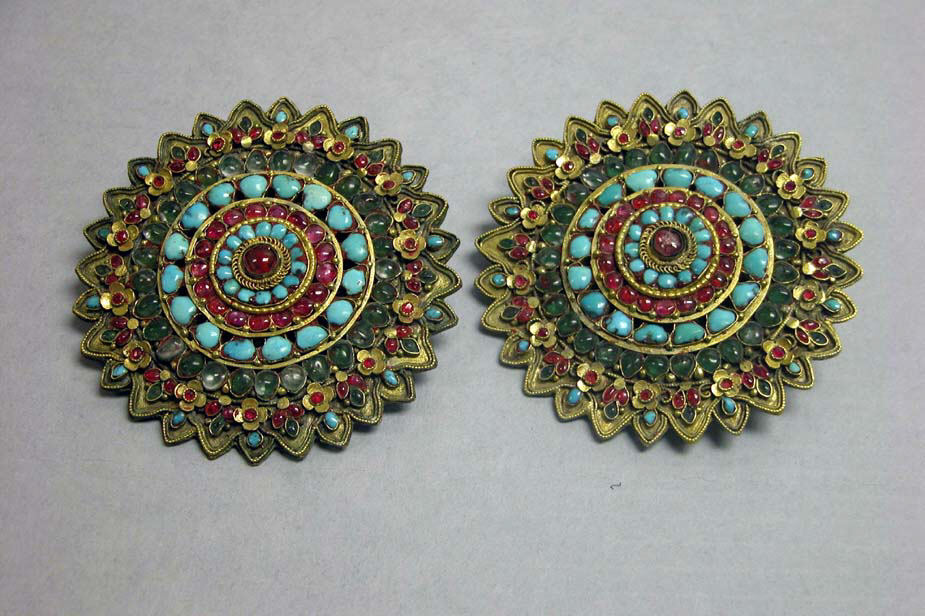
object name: ornament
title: Ornament for deity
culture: nepali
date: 1601-1900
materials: gold, stone